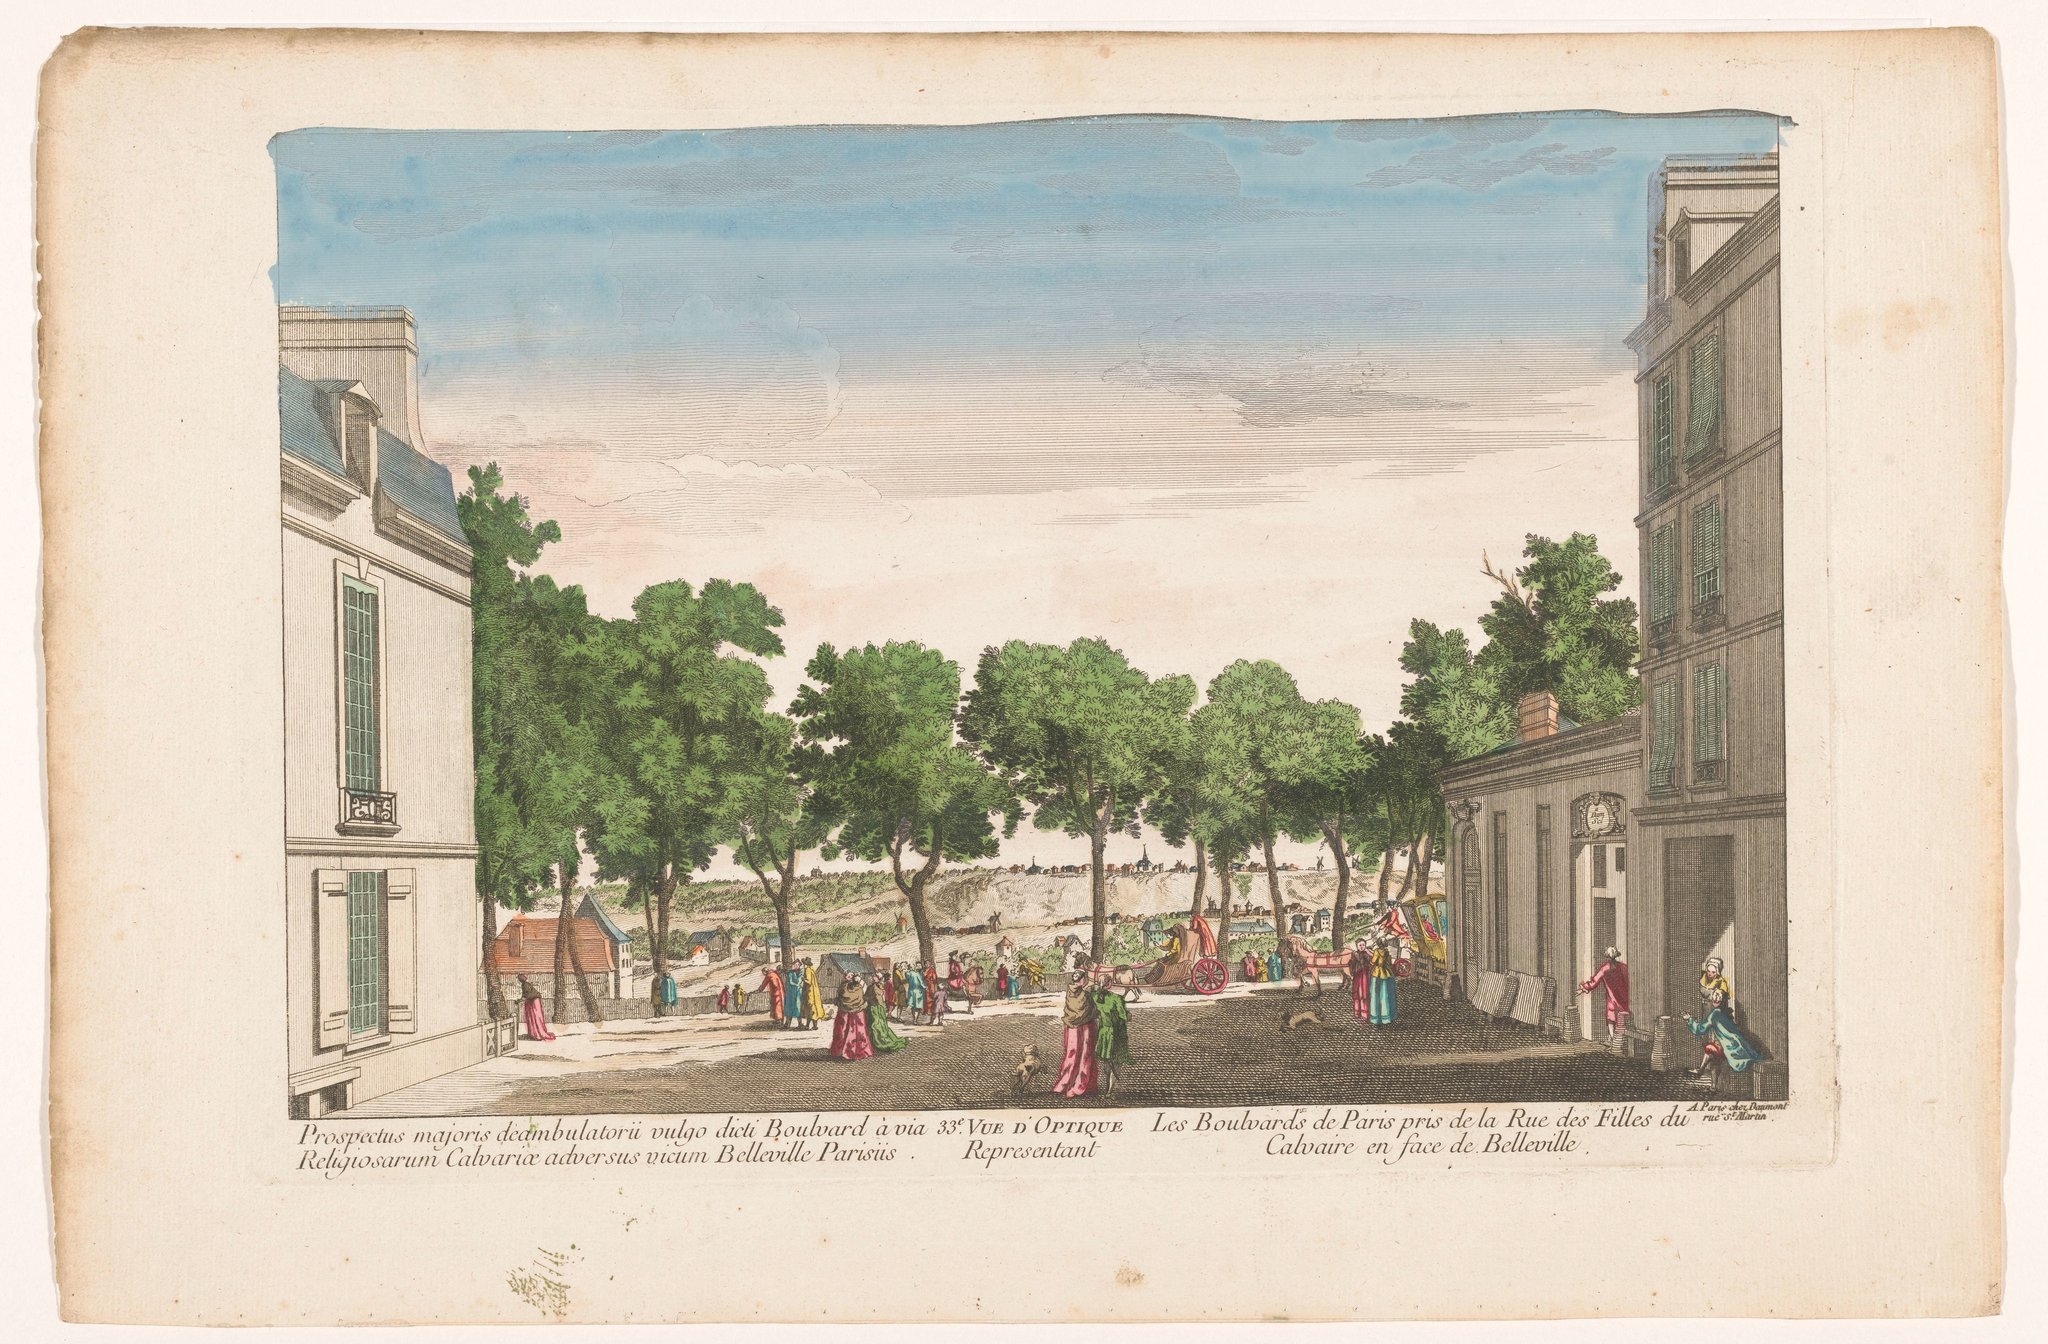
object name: print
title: 33e. Vue d'optique representant les boulvards de Paris pris de la Rue des Filles du Calvaire en face de Belleville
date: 1745-1775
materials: paper, watercolor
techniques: brush, etching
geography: paris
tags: avenue, boulevard, promenade, esplanade (+ city(-scape) with figures, staffage), street (+ city(-scape) with figures, staffage), paris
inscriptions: watermark, collector's mark: Lugt 2166